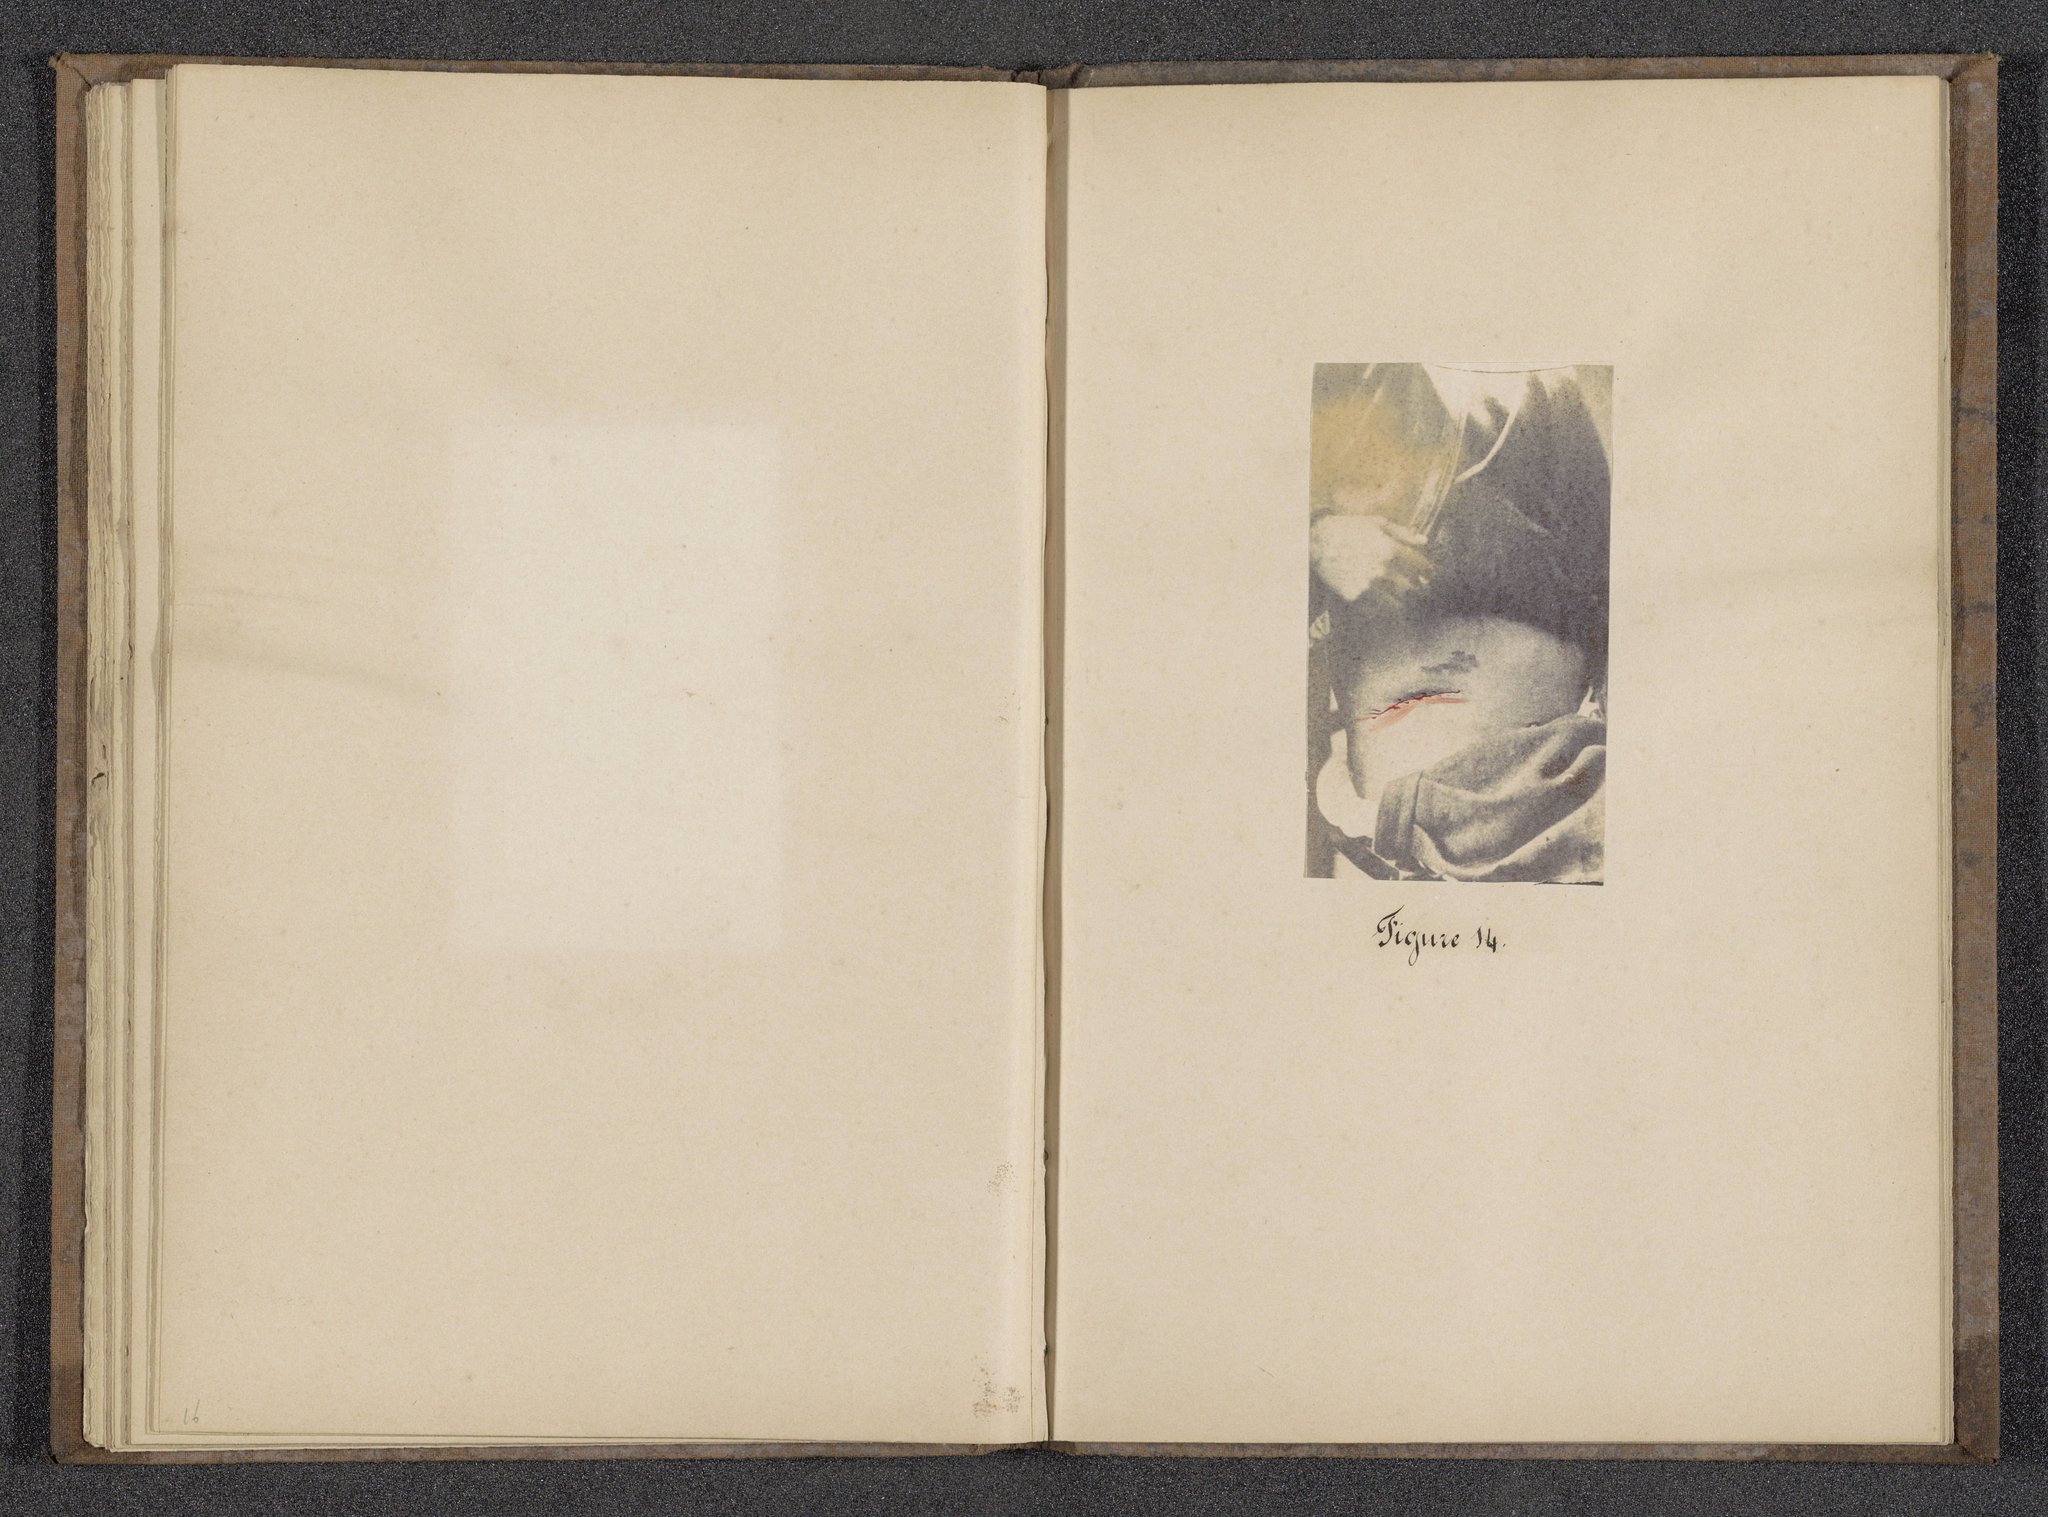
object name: photograph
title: Hussein Sateluiech na een operatie aan zijn darmbeenkam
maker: Anonymous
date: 1878-1880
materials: photographic support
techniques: albumen print, hand coloring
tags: pelvis, operation, surgery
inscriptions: number: ‘Figure 14.’